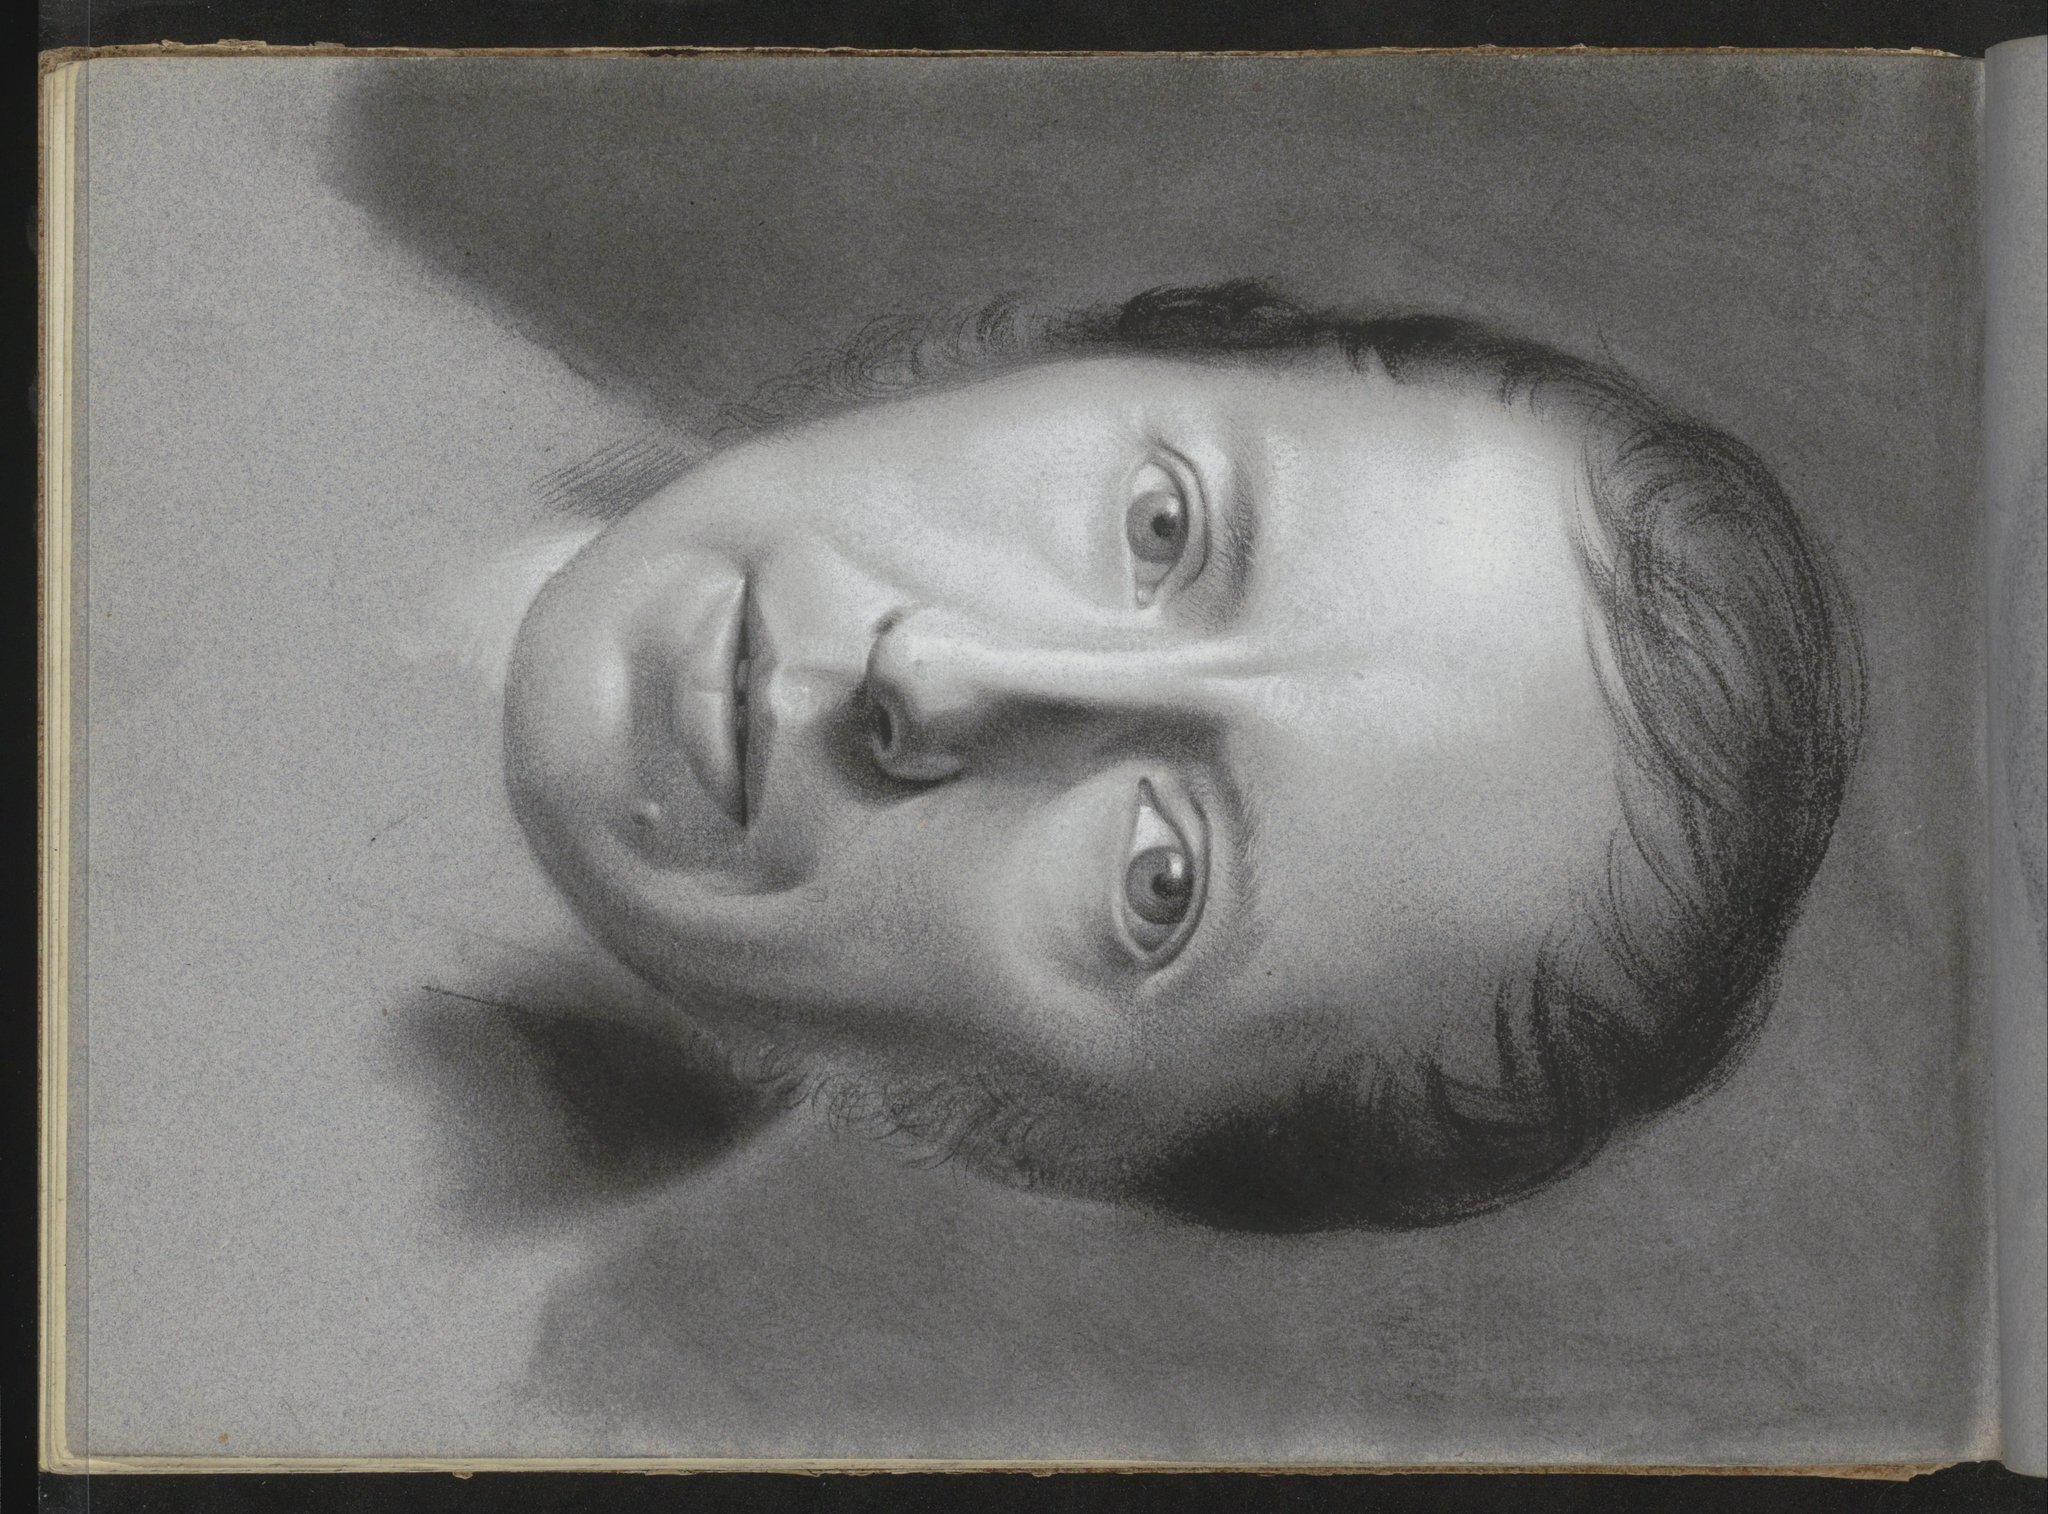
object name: sketchbook leaf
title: Portret van een man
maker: s. altmann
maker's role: painter, print maker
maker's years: 1822-1890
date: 1803-1840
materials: chalk, paper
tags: head (human), anonymous historical person portrayed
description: Blad 14 verso uit een schetsboek met 24 bladen.